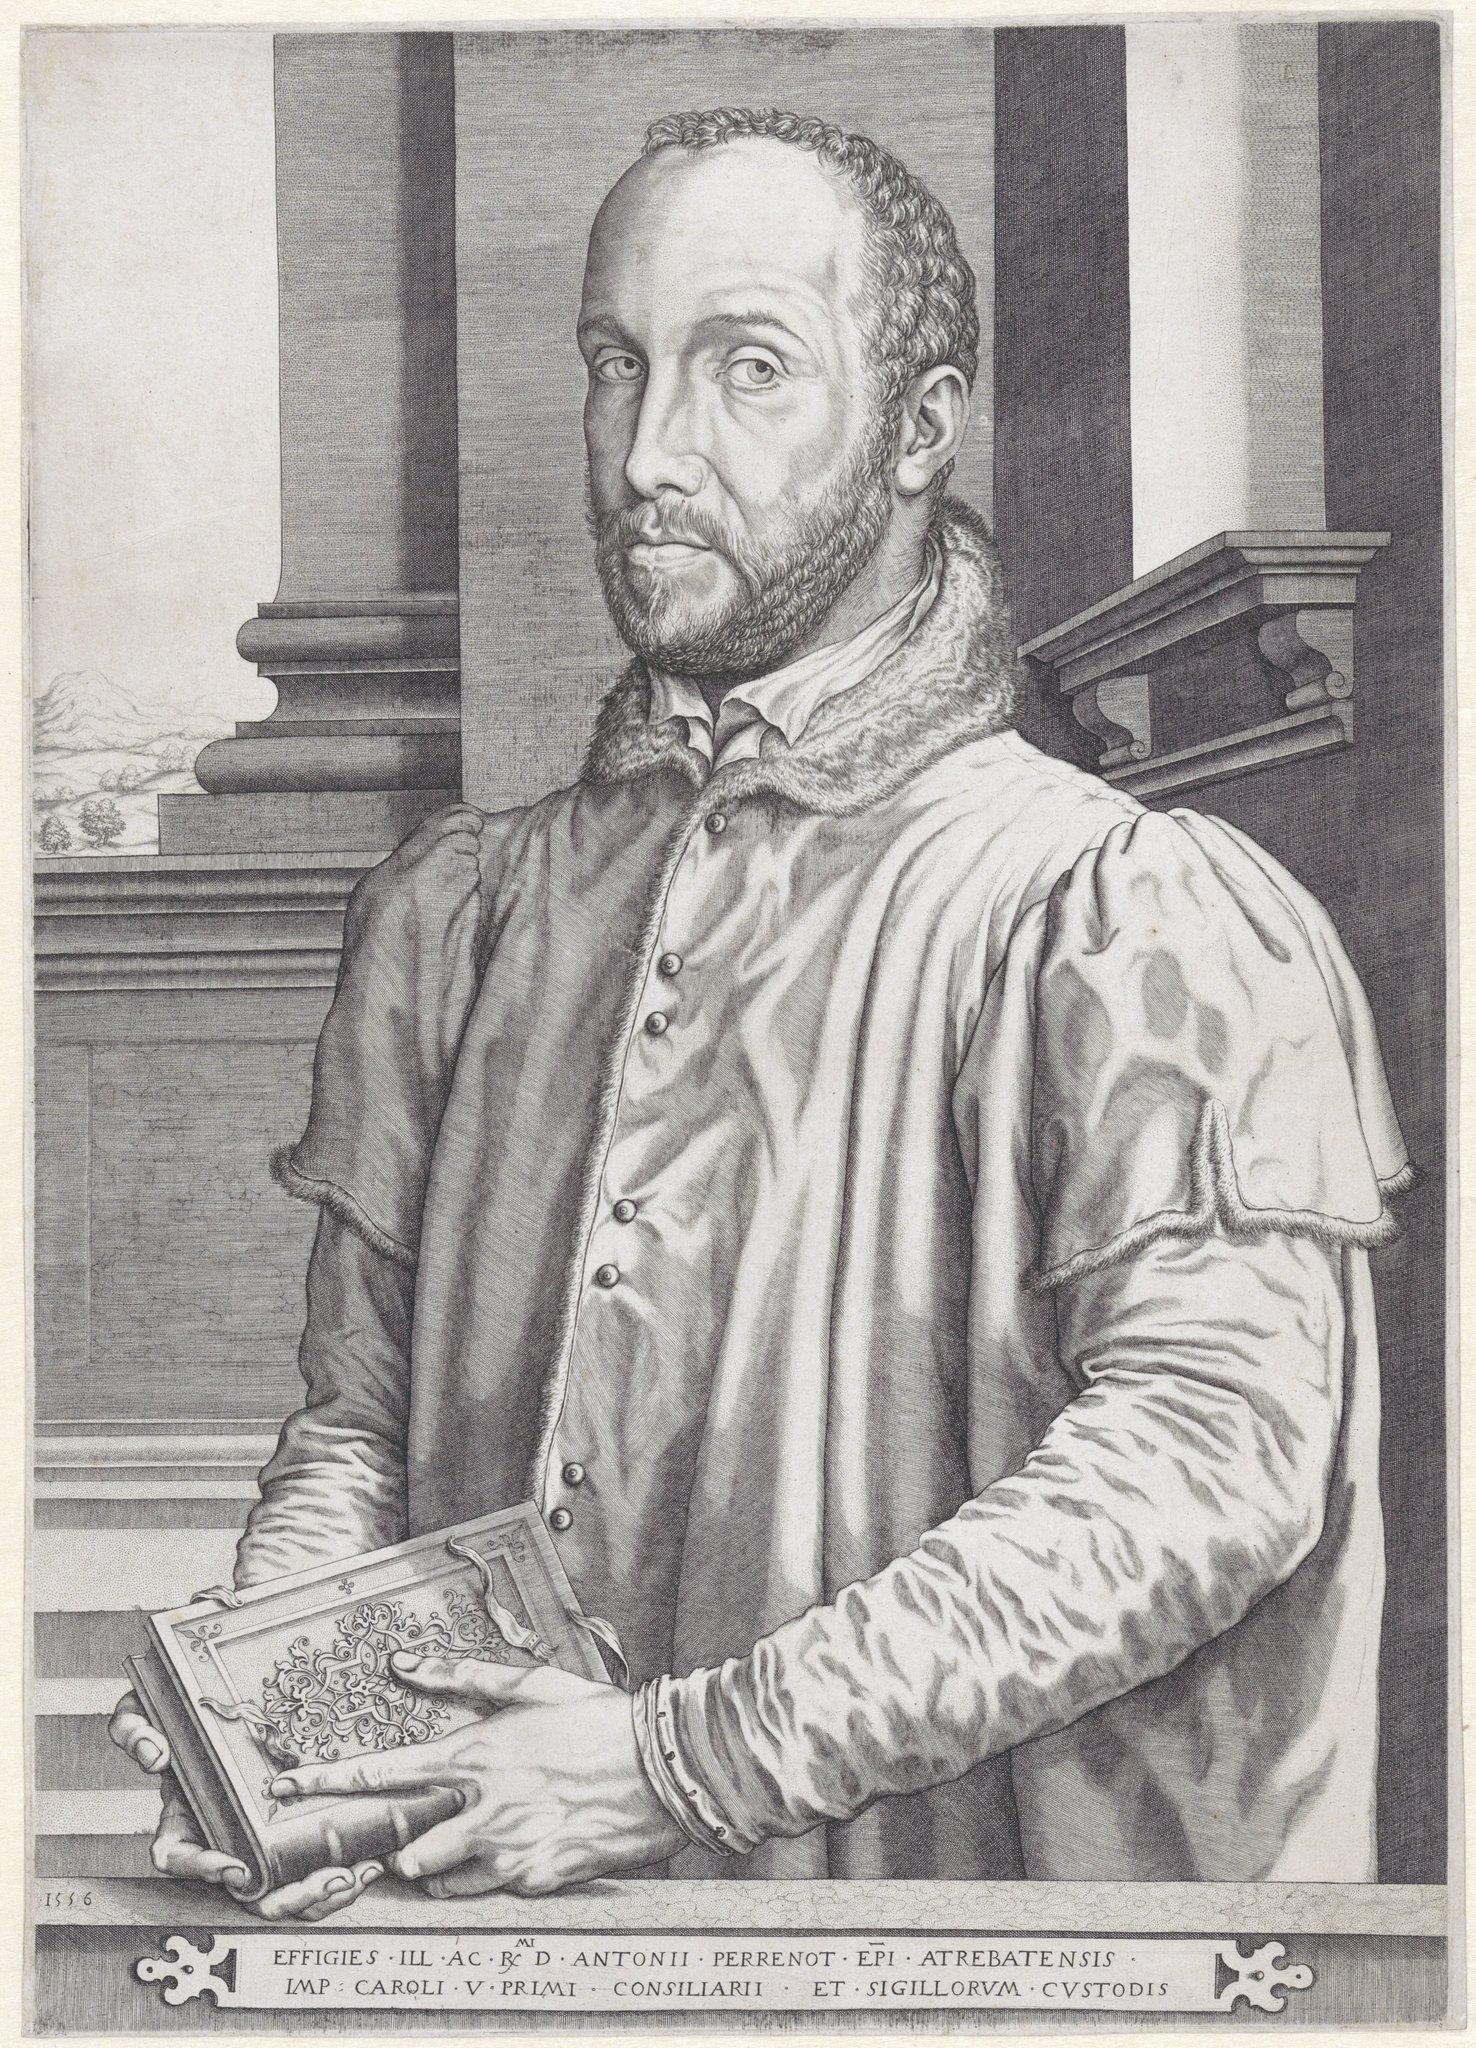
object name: print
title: Portret van Antoine Perrenot kardinaal van Granvelle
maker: lambertus suavius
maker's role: print maker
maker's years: 1514-1564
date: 1556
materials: paper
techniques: engraving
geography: southern netherlands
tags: antoine perrenot de granvelle, book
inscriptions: collector's mark: Lugt 151, collector's mark: Lugt 2004, collector's mark: Lugt 2760, collector's mark: Lugt 2166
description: Perrenot de Granvelle (1517-1586) was staatsman in dienst van de Habsburgs en werd op 21-jarige leeftijd bisschop van Atrecht. Op latere leeftijd werd hij een van de invloedrijkste raadgevers van de landvoogdes Margaretha van Parma. Granvelle had grote belangstelling voor kunsten en wetenschappen. Het boek in zijn hand verwijst naar deze interesse. Granvelle heeft mogelijk zelf de wens te kennen gegeven om als een geleerde in plaats van als staatsman en kerkelijk prelaat te worden geportretteerd.